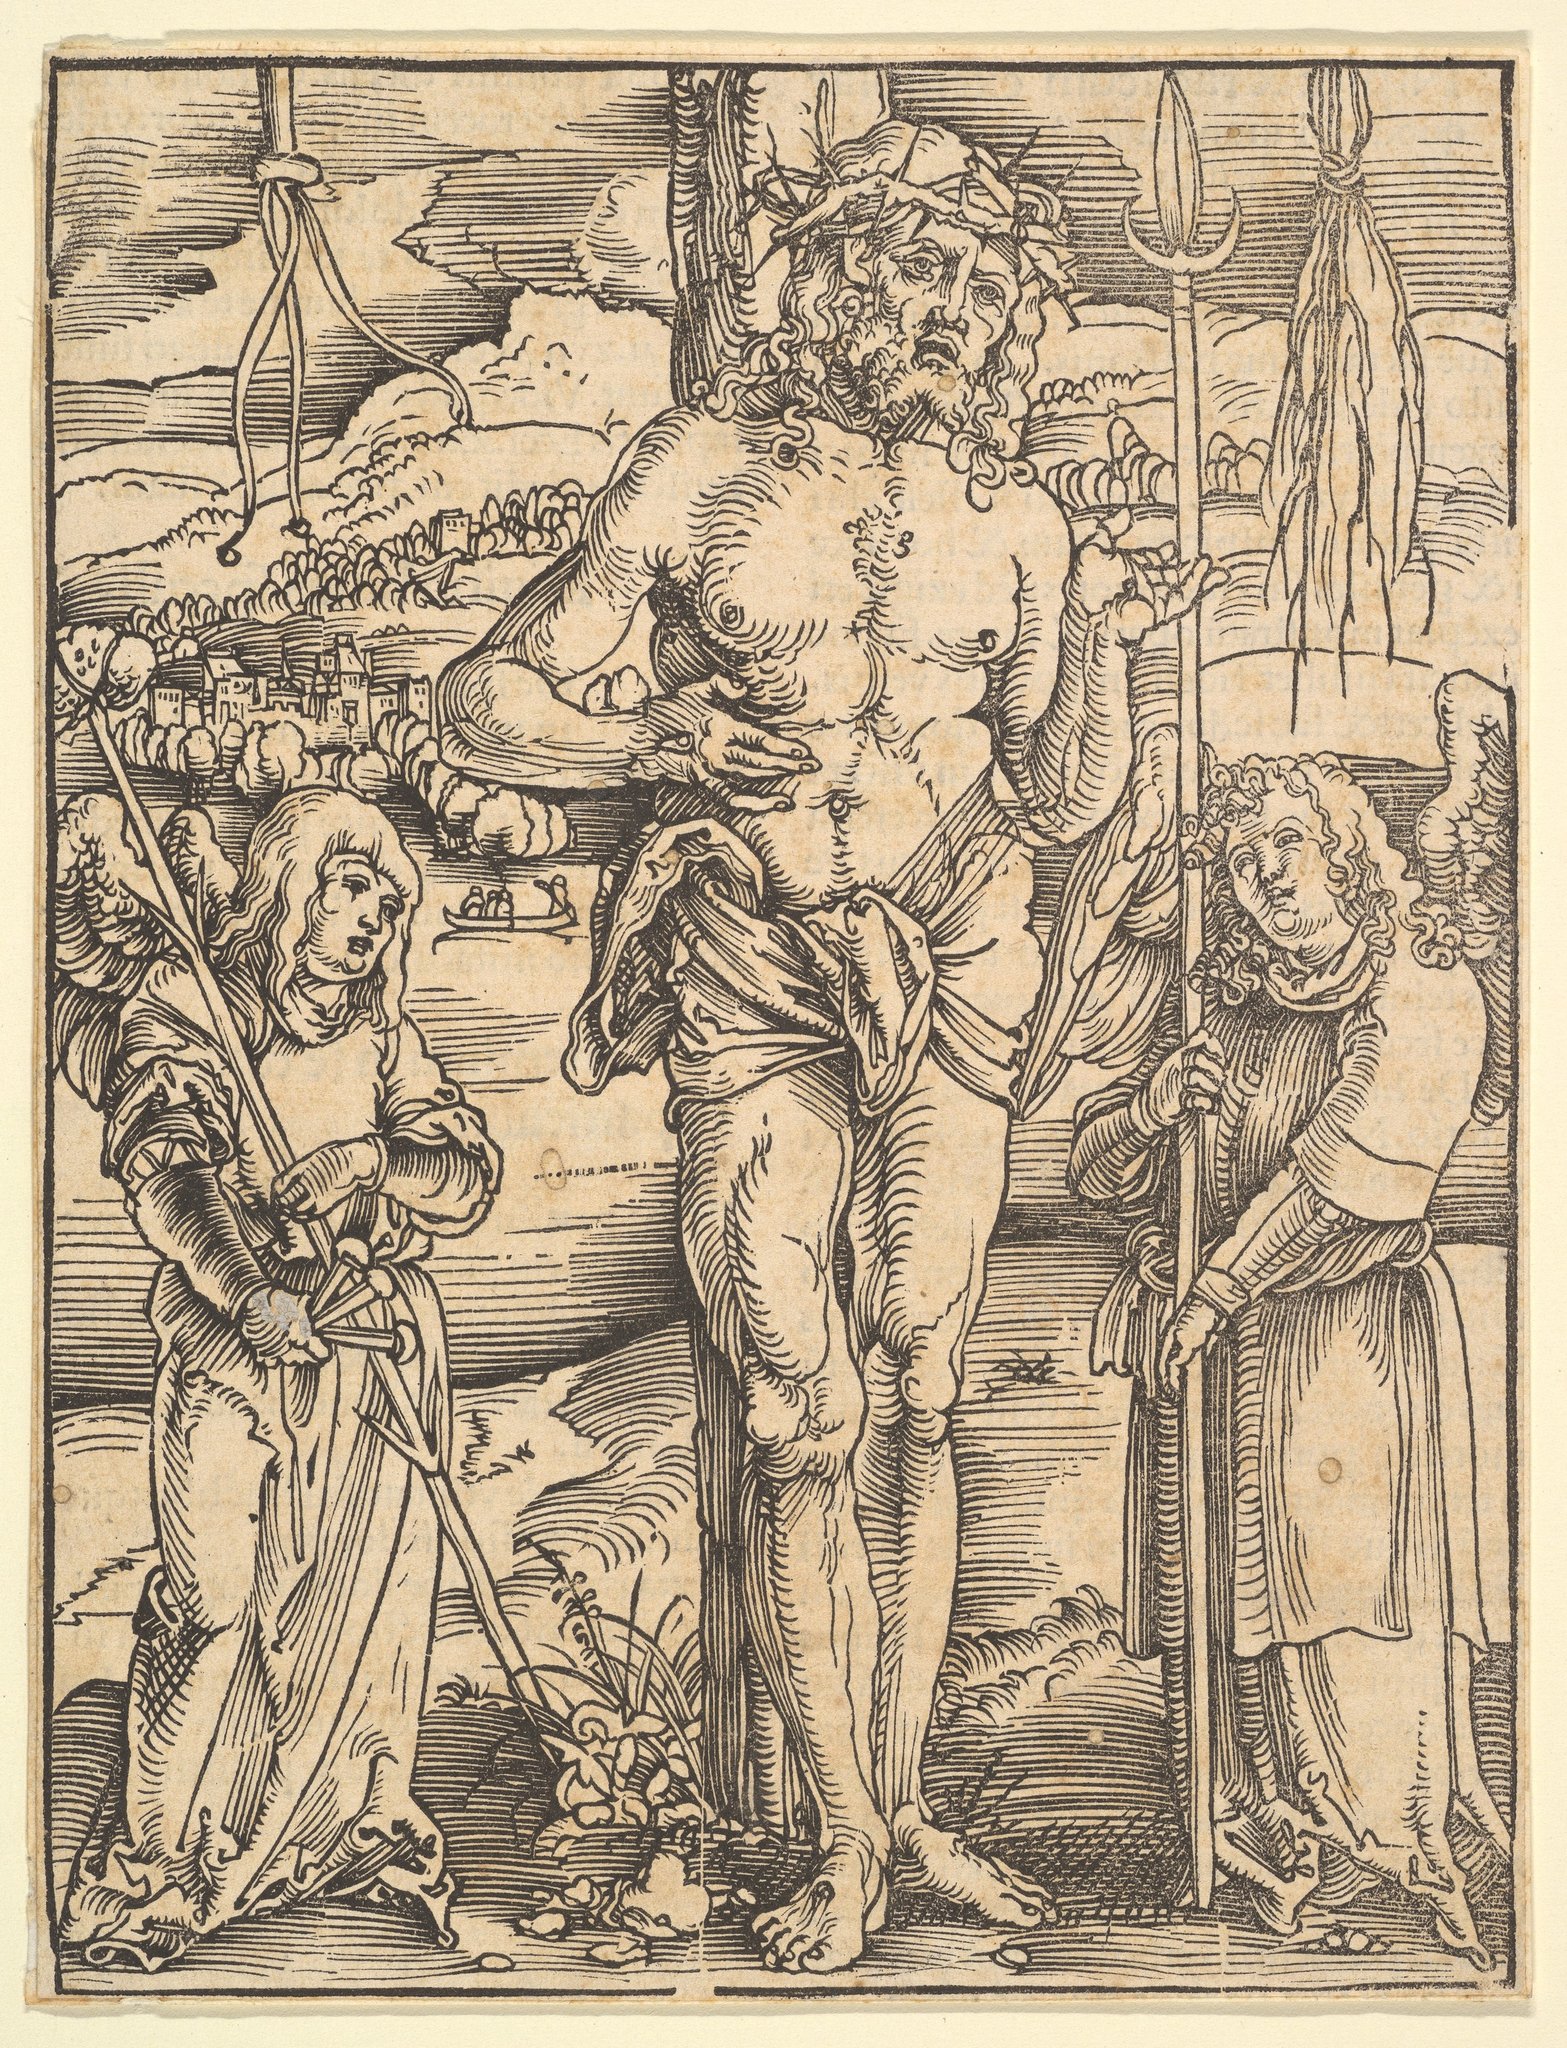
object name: print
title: Man of Sorrows, from Speculum Passionis Domini Nostri Ihesu Christi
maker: hans baldung (called hans baldung grien)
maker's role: artist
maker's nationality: german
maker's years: 1484-1545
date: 1507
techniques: woodcut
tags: sadness,angels,christ